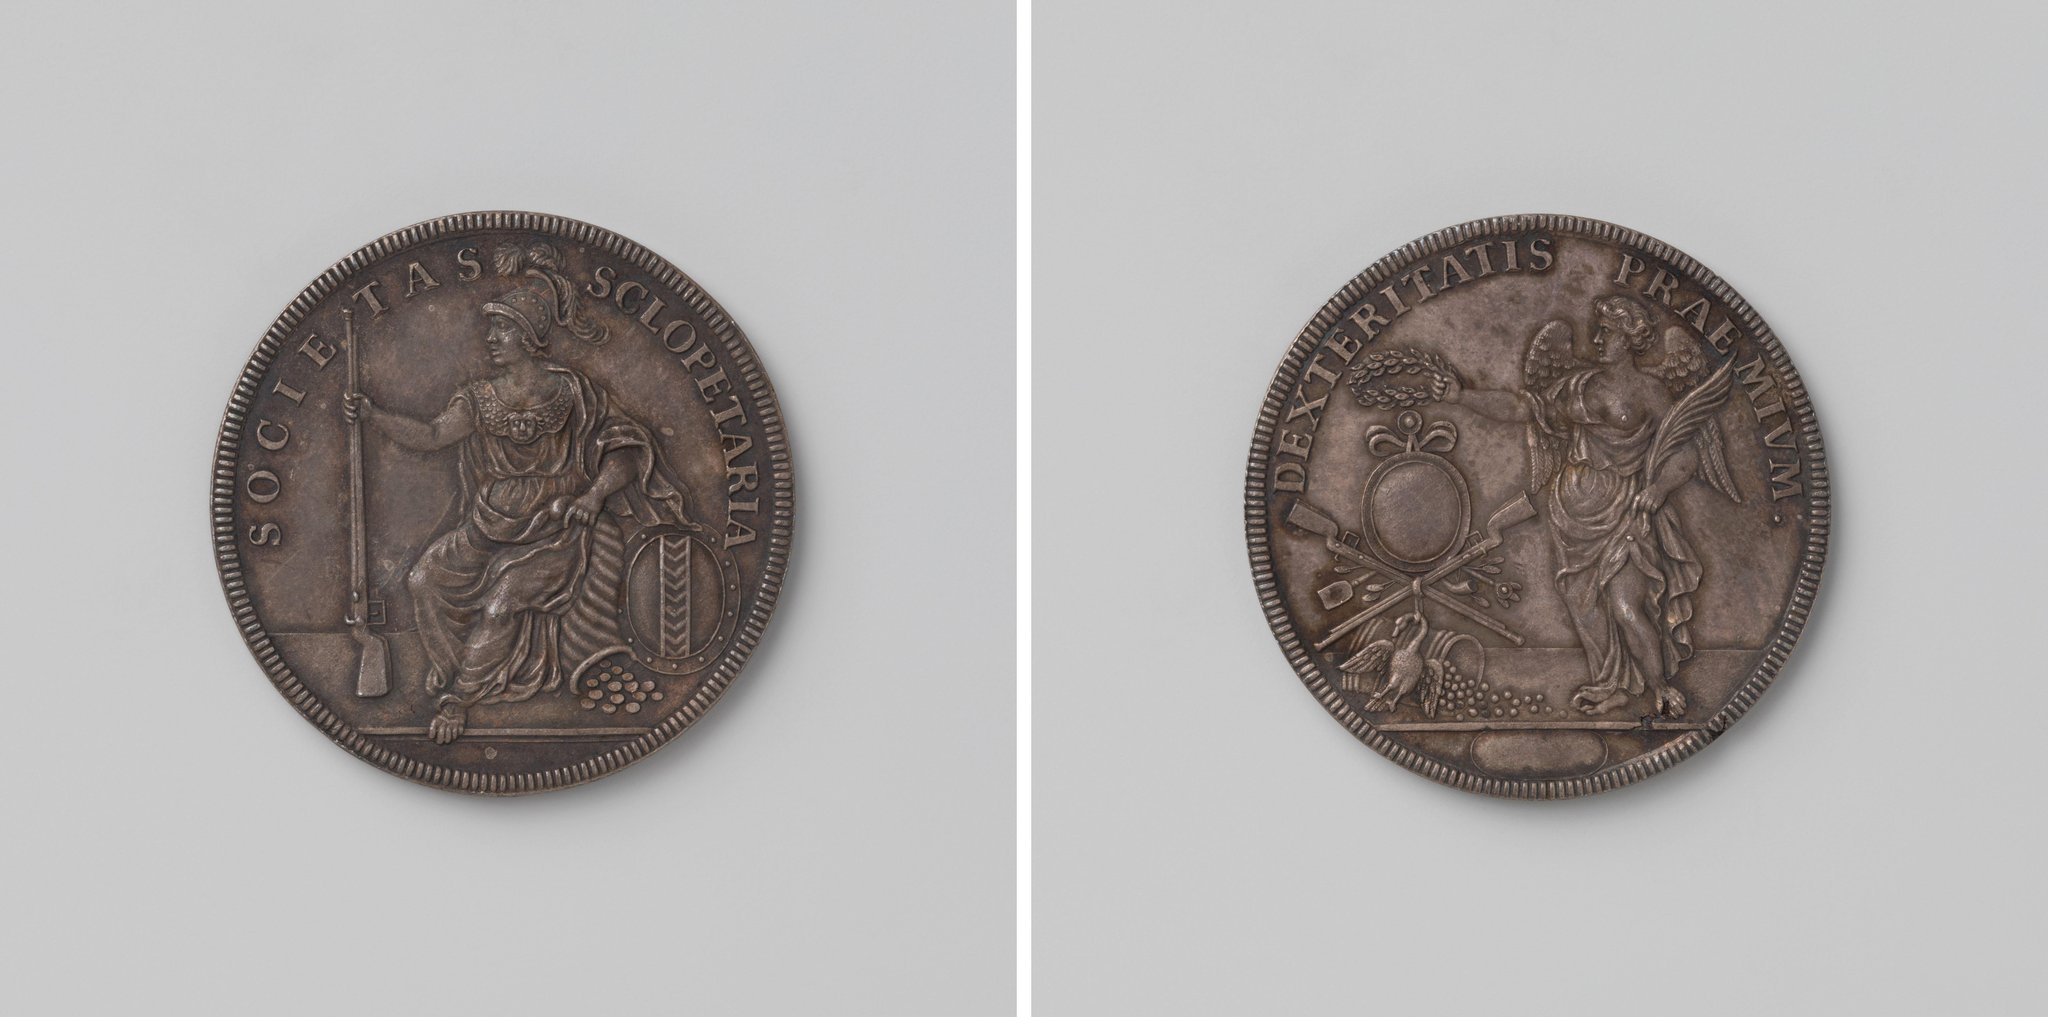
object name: koningspenning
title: Ridderlijke Confrerie van de Handbussche te Delft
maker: gerard van loon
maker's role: designer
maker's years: 1683-1758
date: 1718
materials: silver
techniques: striking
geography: netherlands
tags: delft